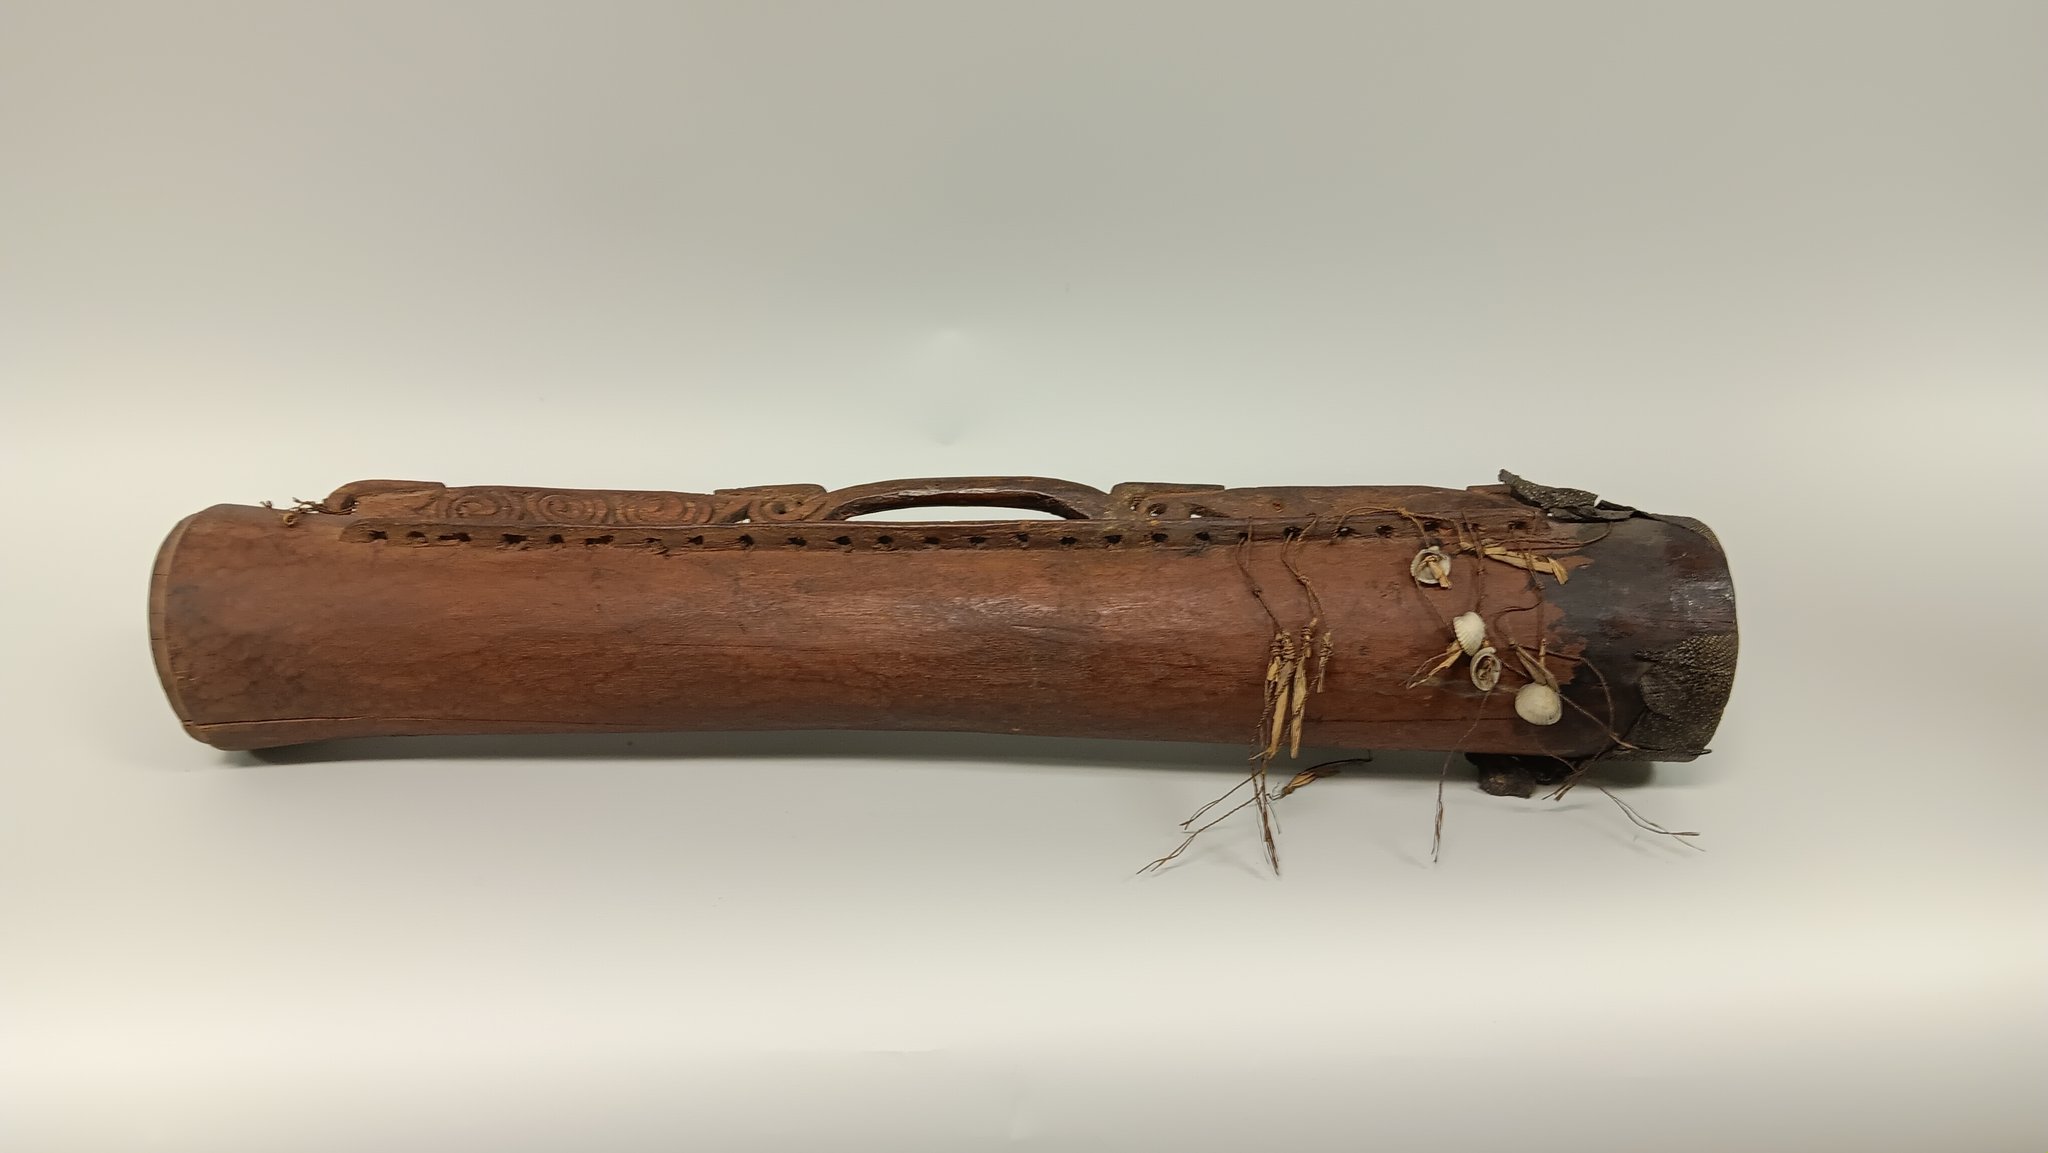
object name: kundu drum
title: Kundu (drum)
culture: melanesian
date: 1867-1900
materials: fiber, shell, skin, wood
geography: papua new guinea